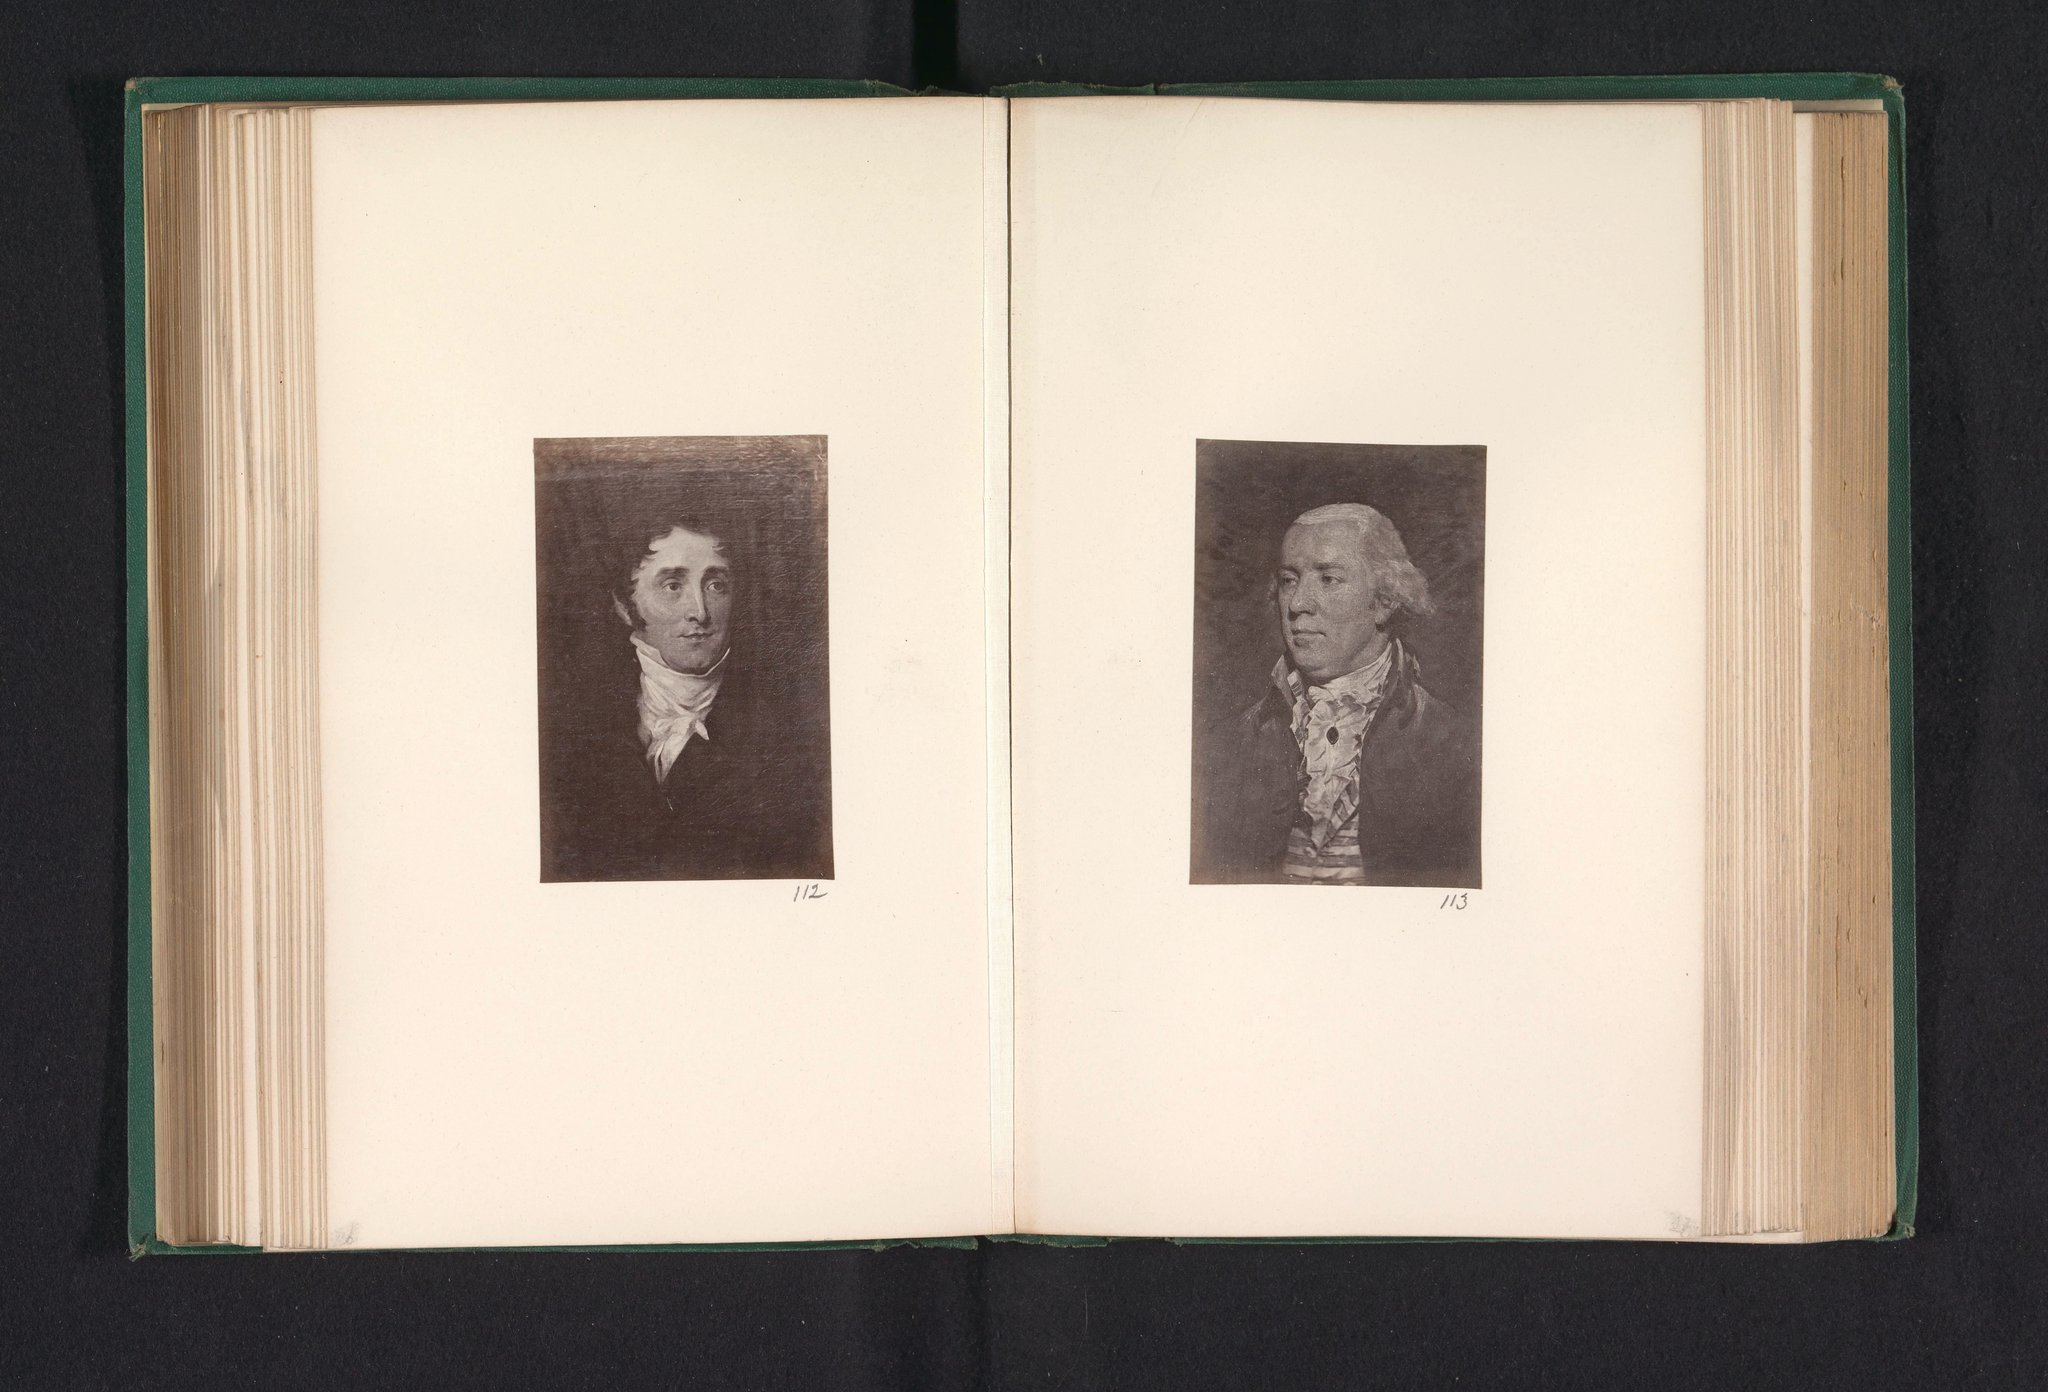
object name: photograph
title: Fotoreproductie van een schilderij, voorstellende een portret van John Smith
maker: thomas annan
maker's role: fotograaf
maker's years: 1829-1887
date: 1863-1868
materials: photographic support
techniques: albumen print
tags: historical persons (portraits and scenes from the life) (+ (full) bust portrait)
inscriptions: number: ‘113’